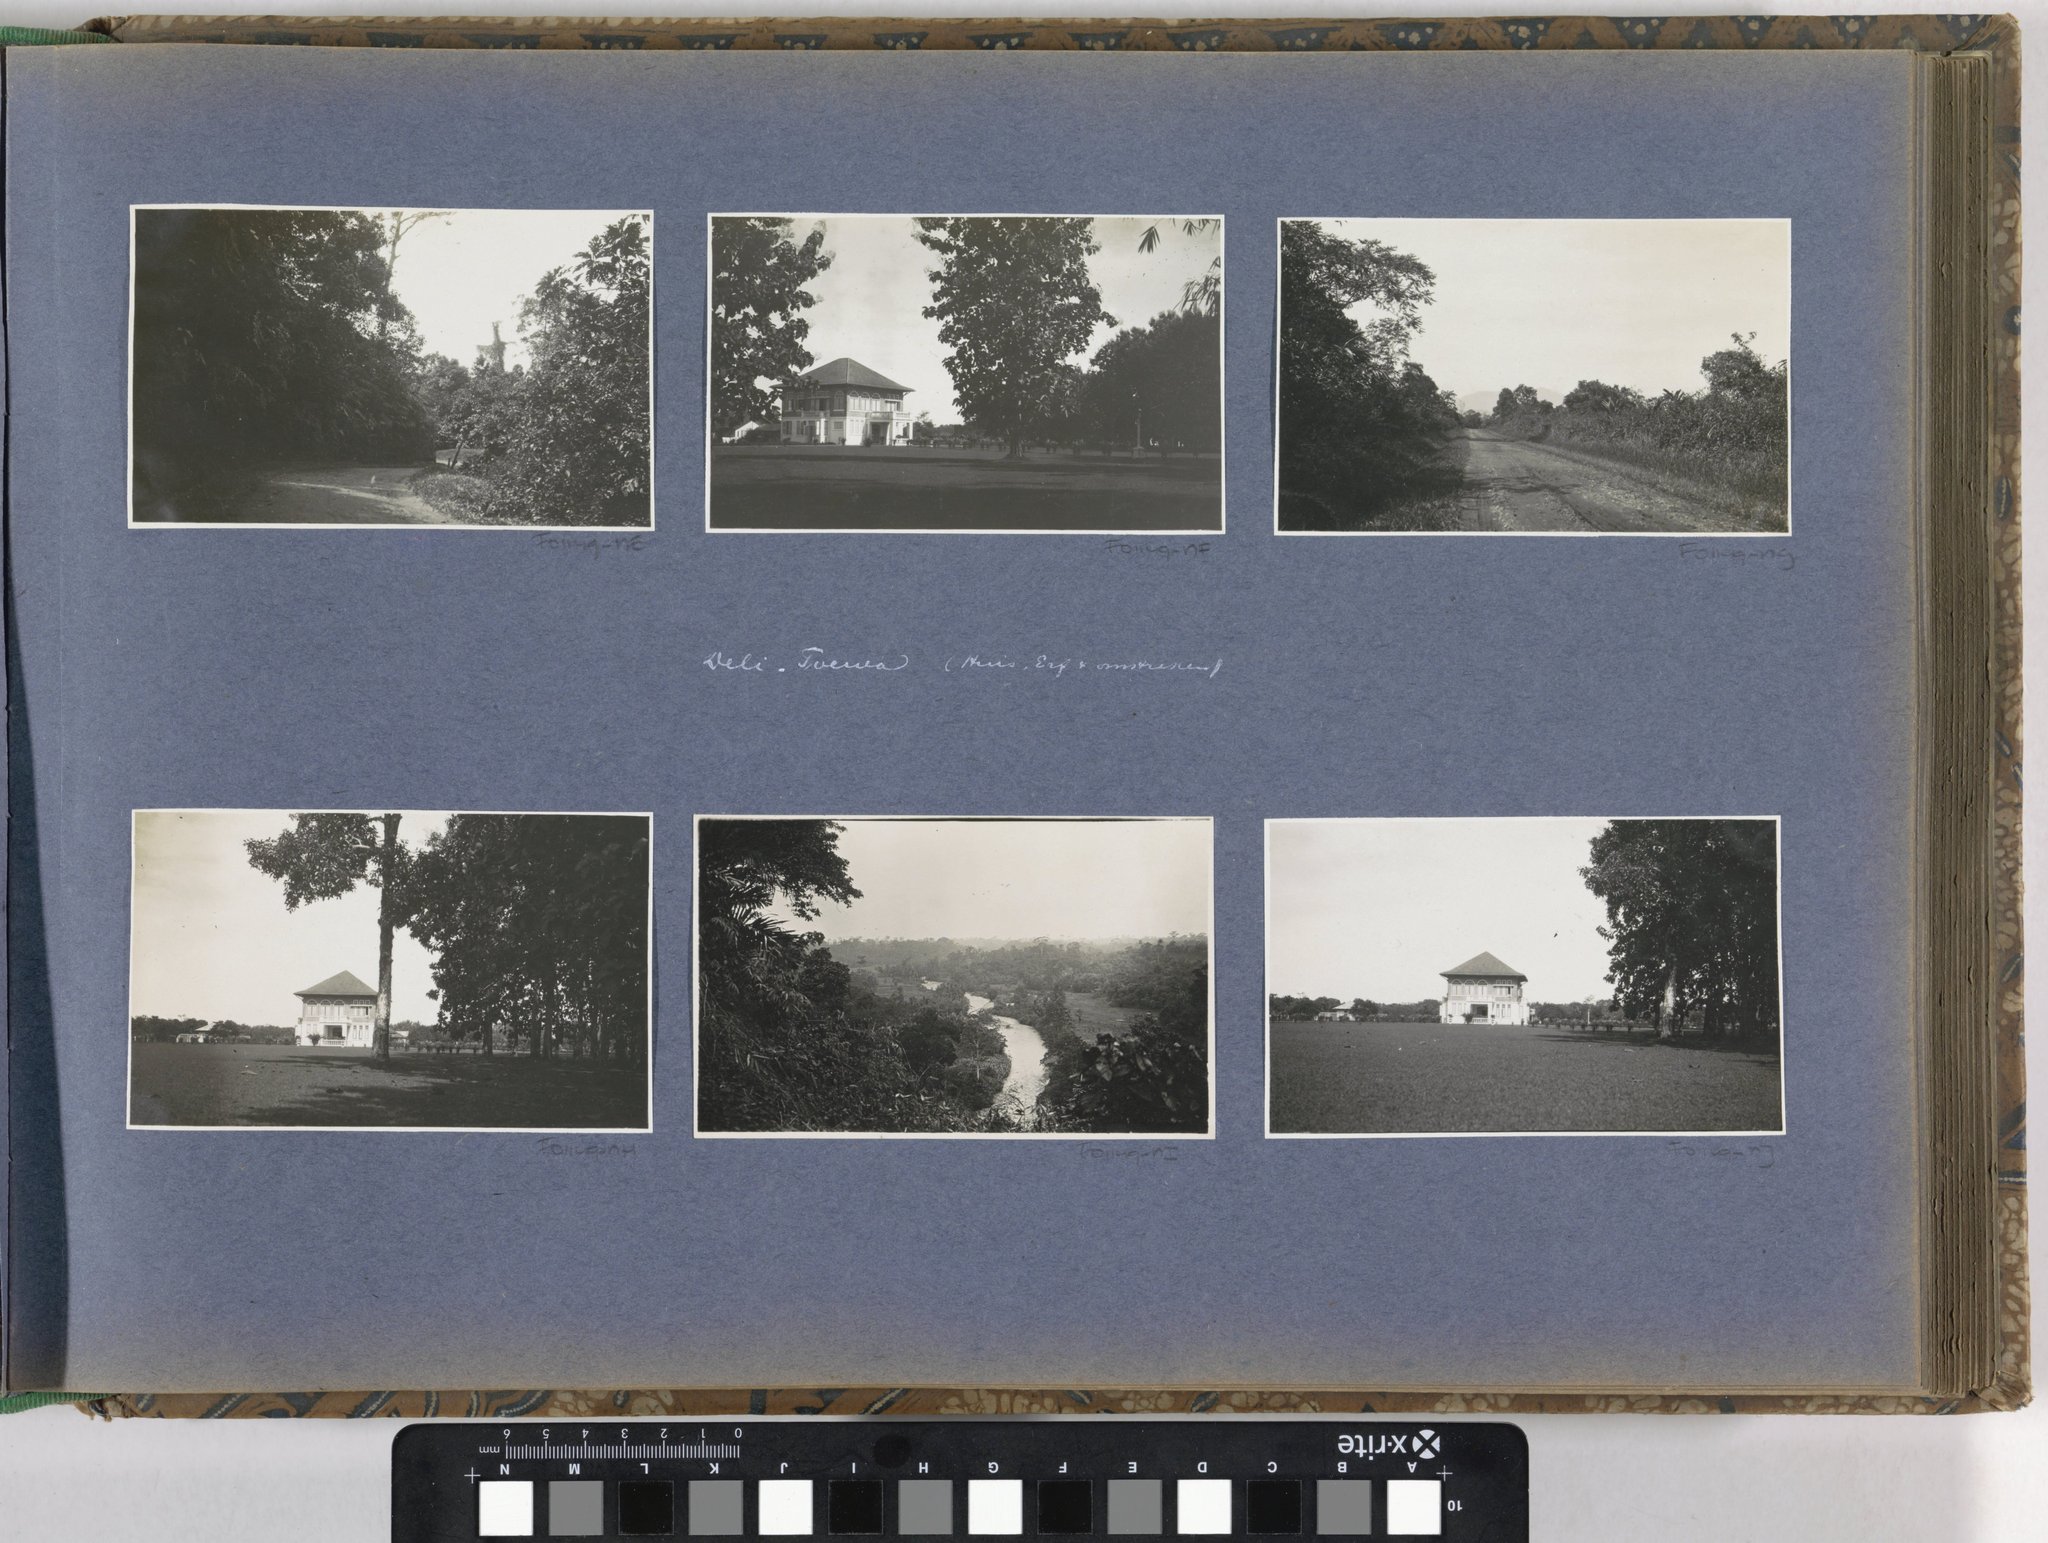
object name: photograph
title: Tuin in Deli-Toewa op Sumatra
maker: Anonymous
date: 1900-1920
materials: paper, photographic support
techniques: gelatin silver print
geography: sumatra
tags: plantation, garden, sumatra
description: Onderdeel van reisalbum met foto's van bedrijvigheid en bezienswaardigheden op Sumatra en Java en van de reis naar en van Nederlands-Indië.